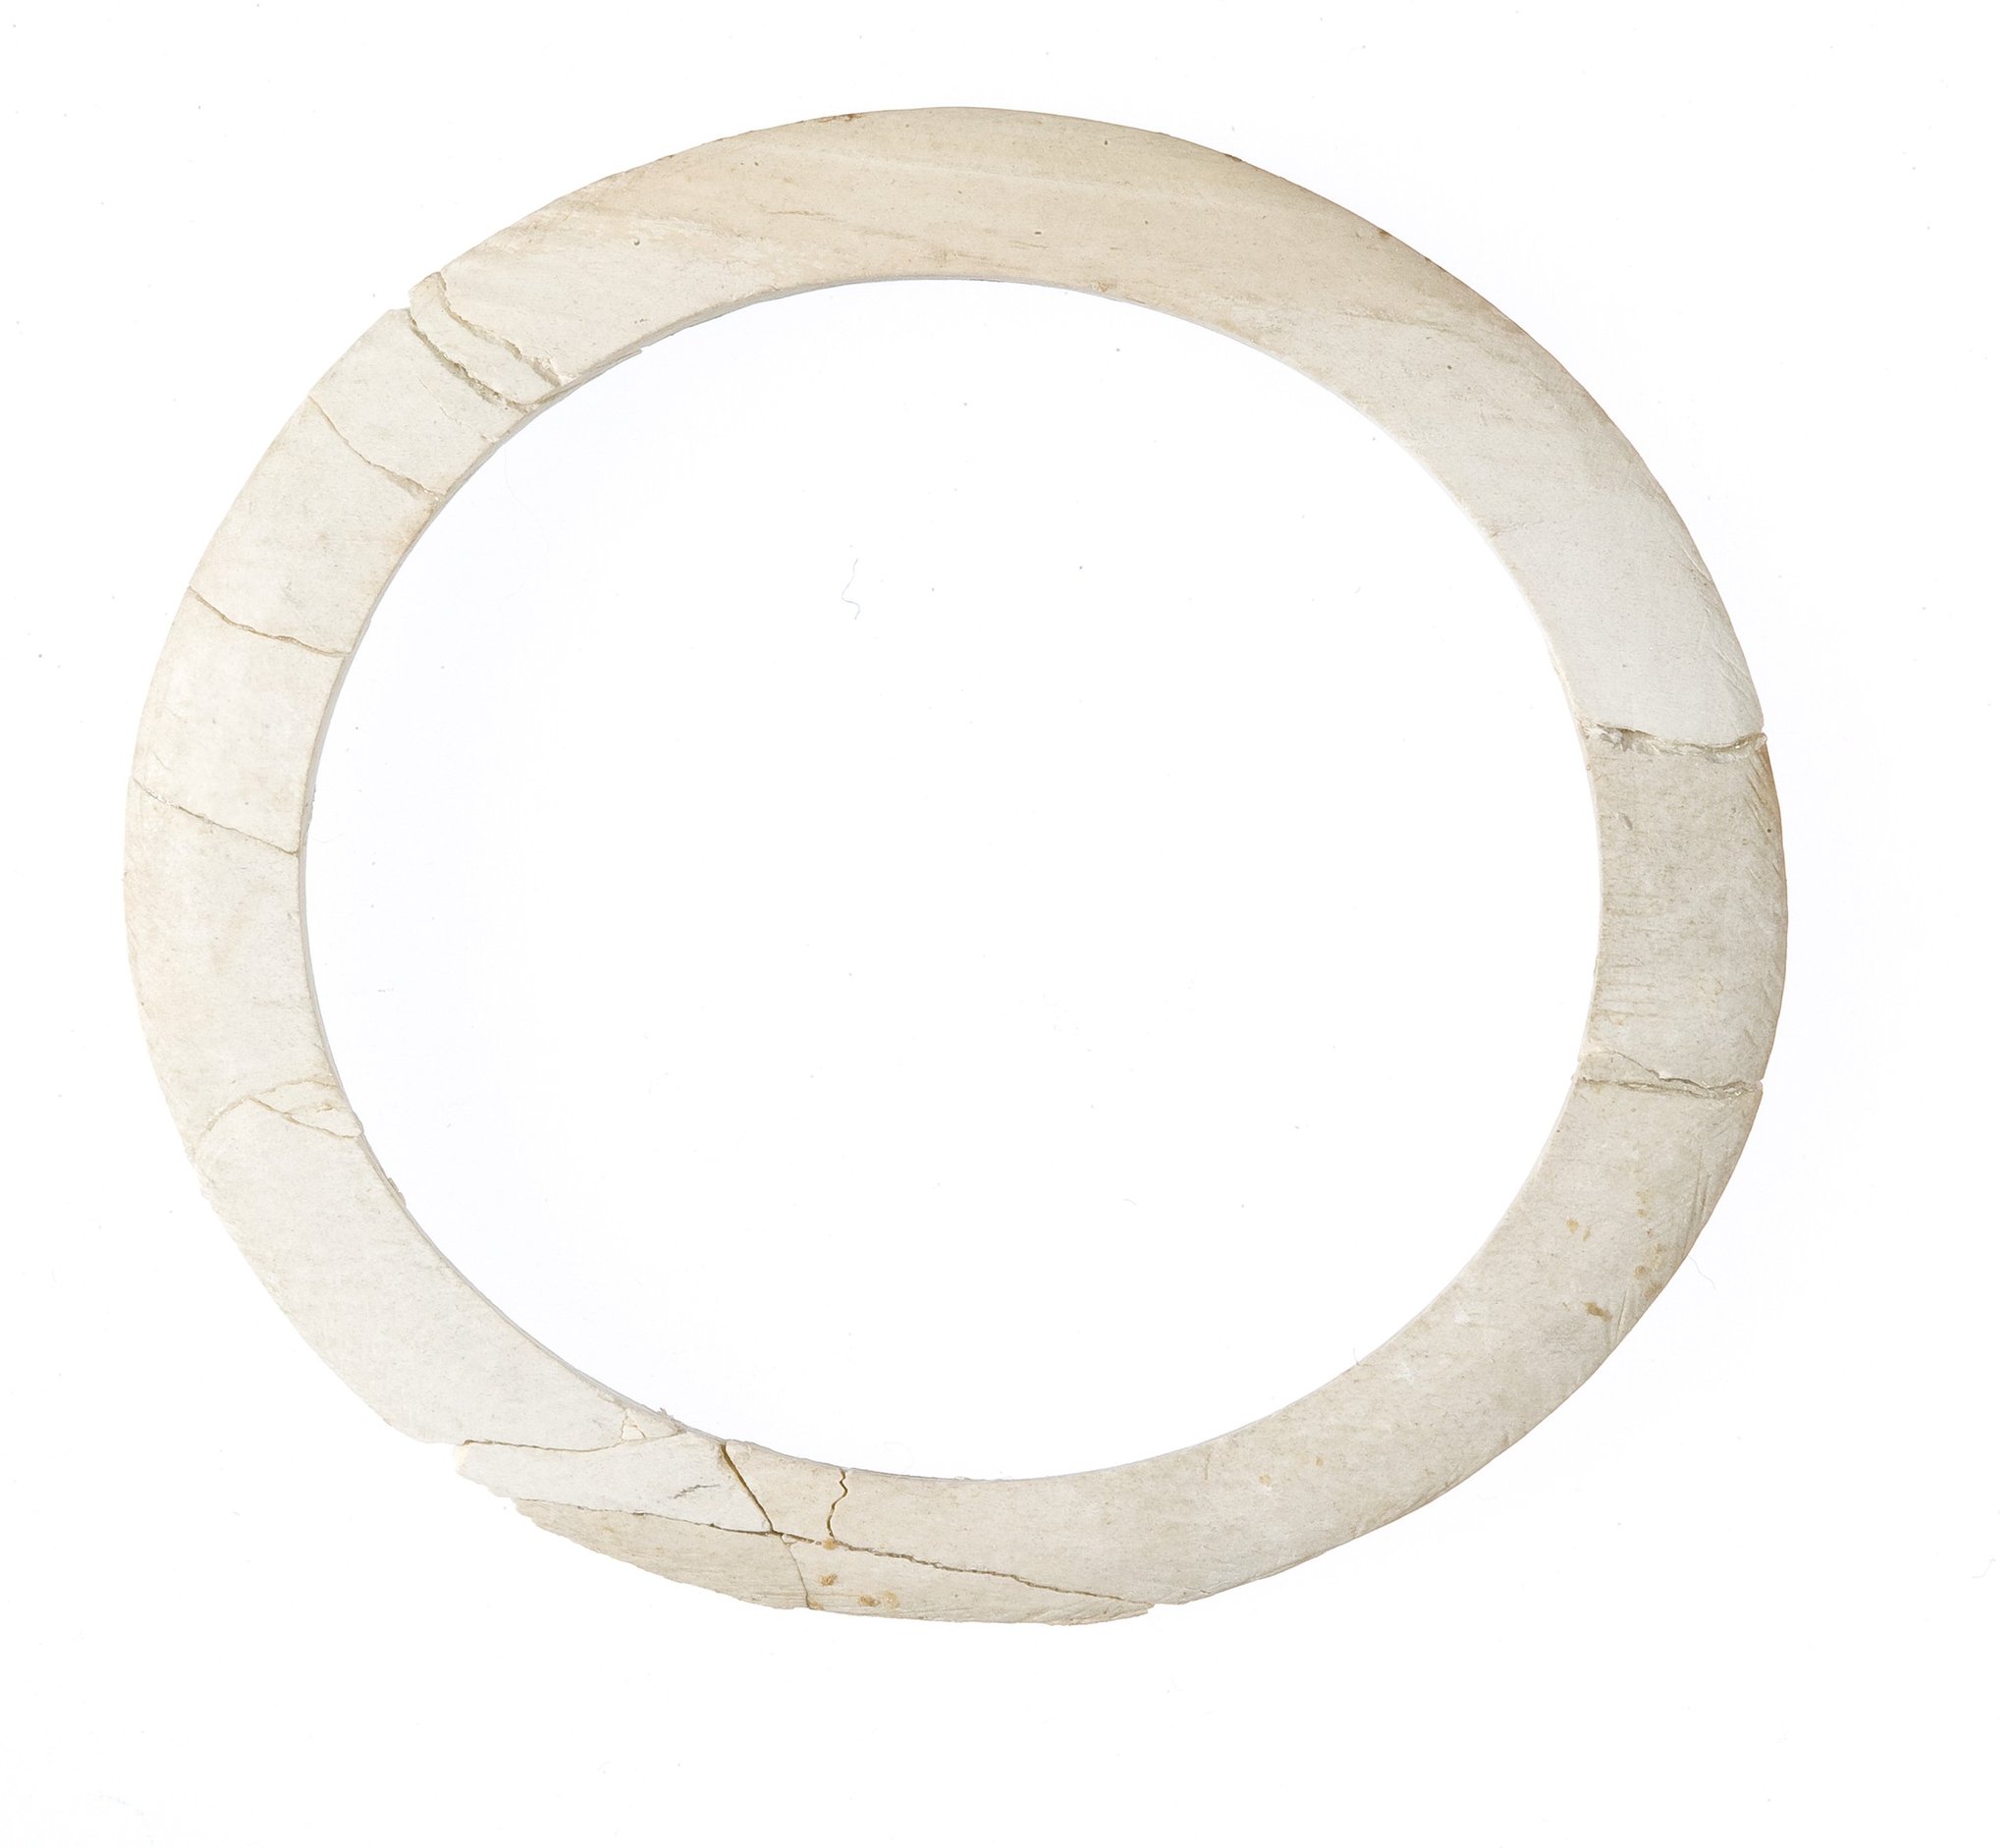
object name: bracelet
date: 1635-1458 BCE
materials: ivory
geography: egypt